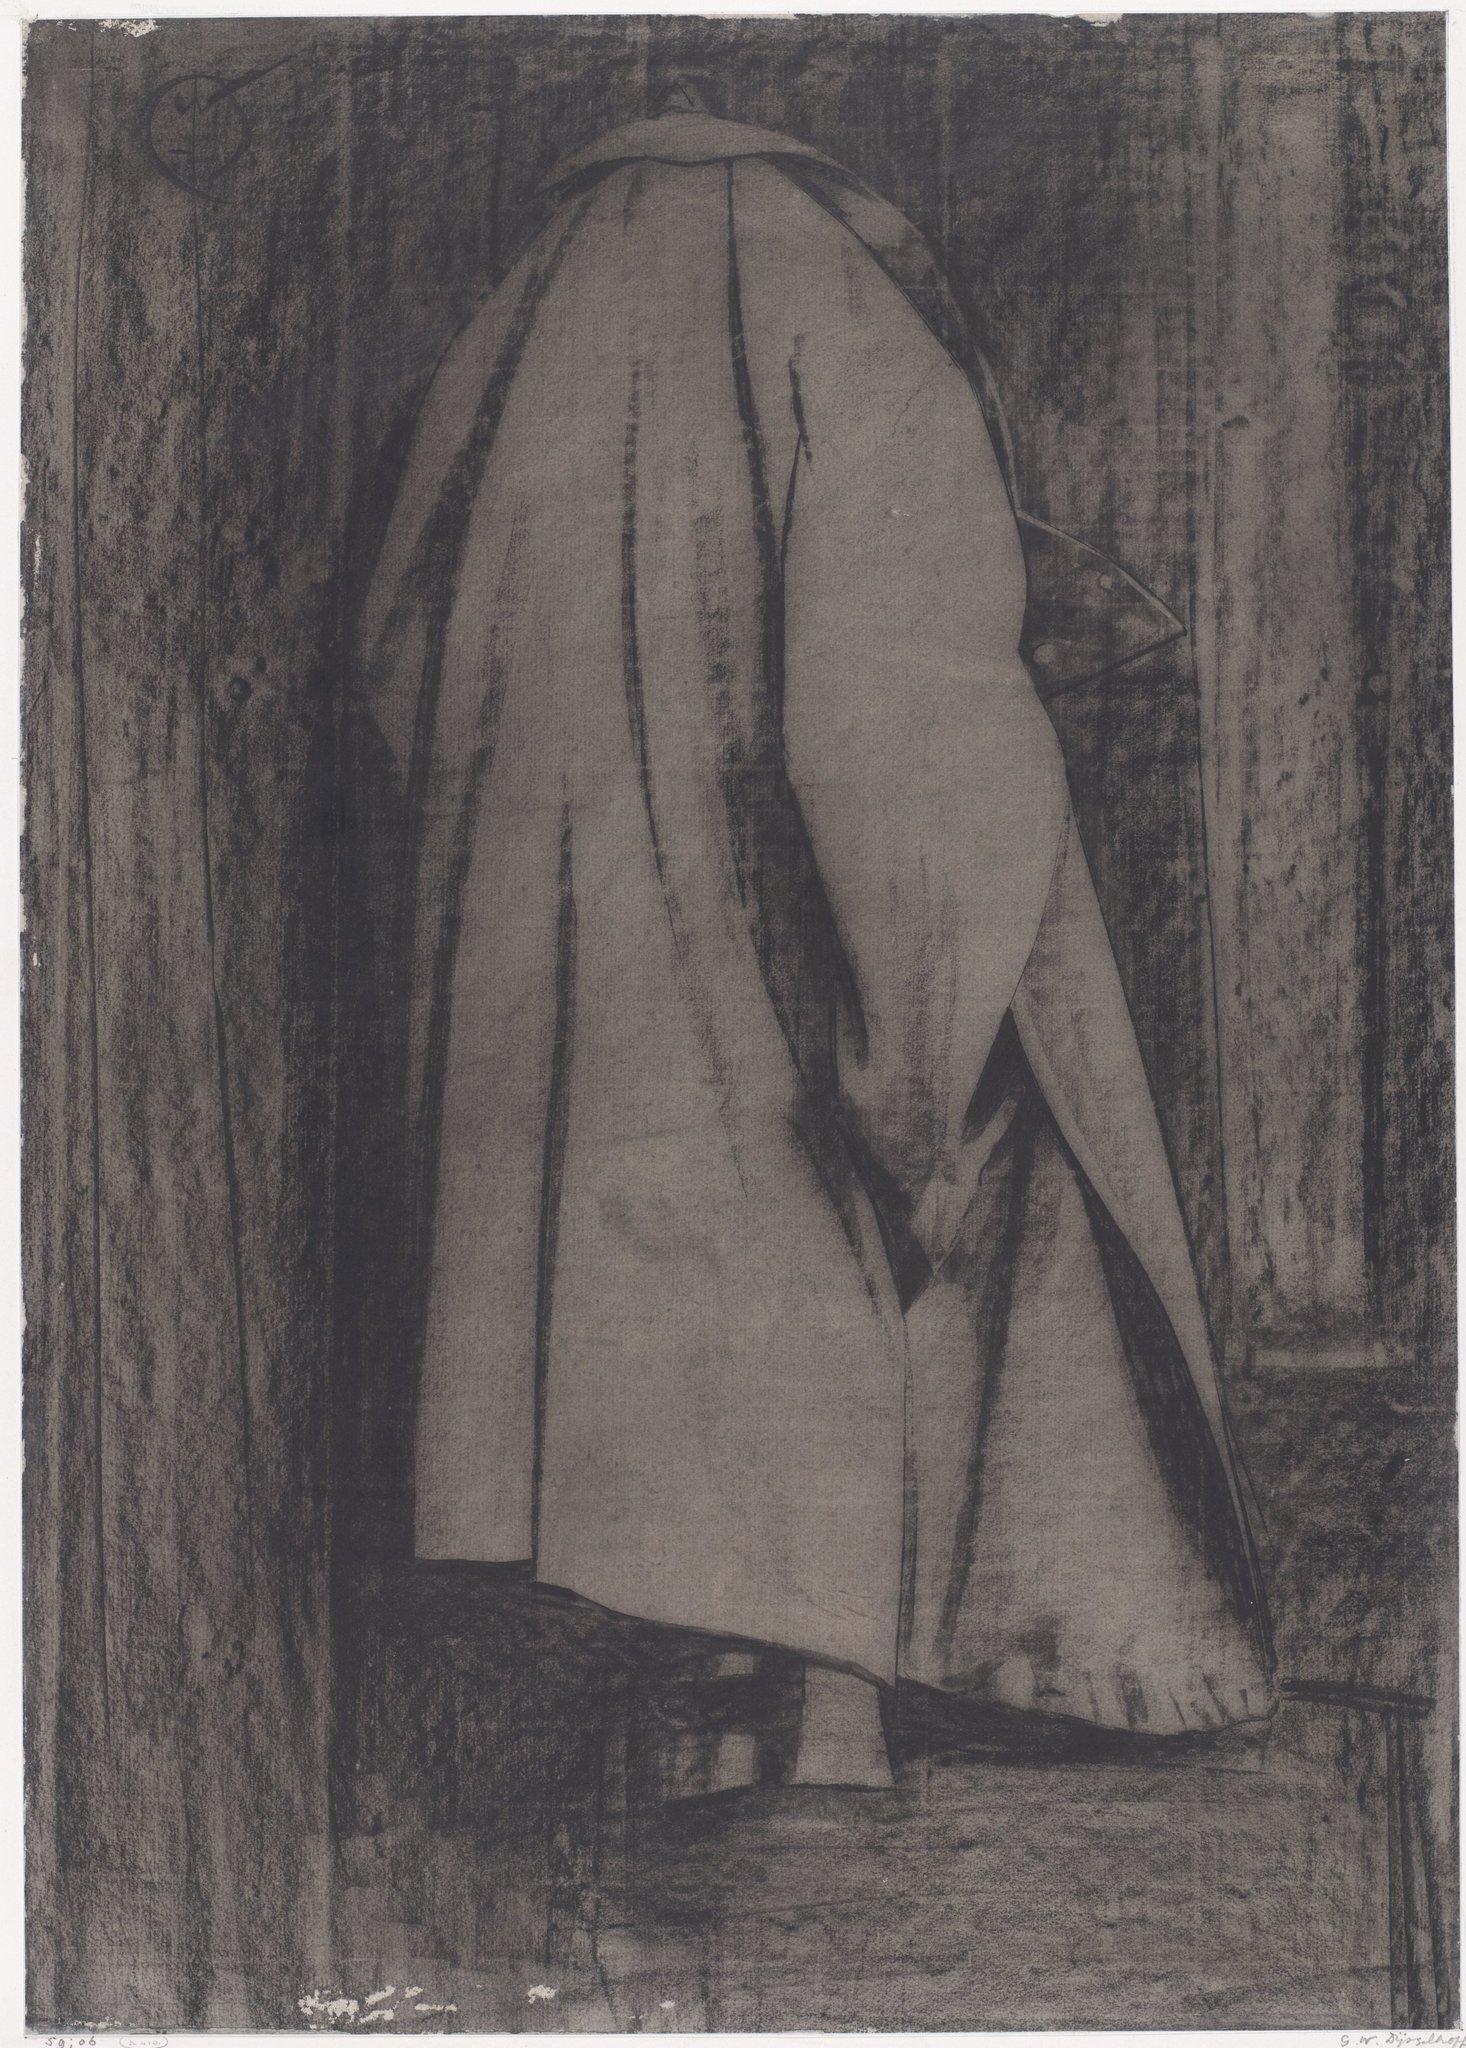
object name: drawing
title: Hangende jas in een donker interieur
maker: gerrit willem dijsselhof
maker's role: designer, draughtsman, print maker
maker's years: 1866-1924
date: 1876-1924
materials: chalk, paper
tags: coat (+ men's clothes)